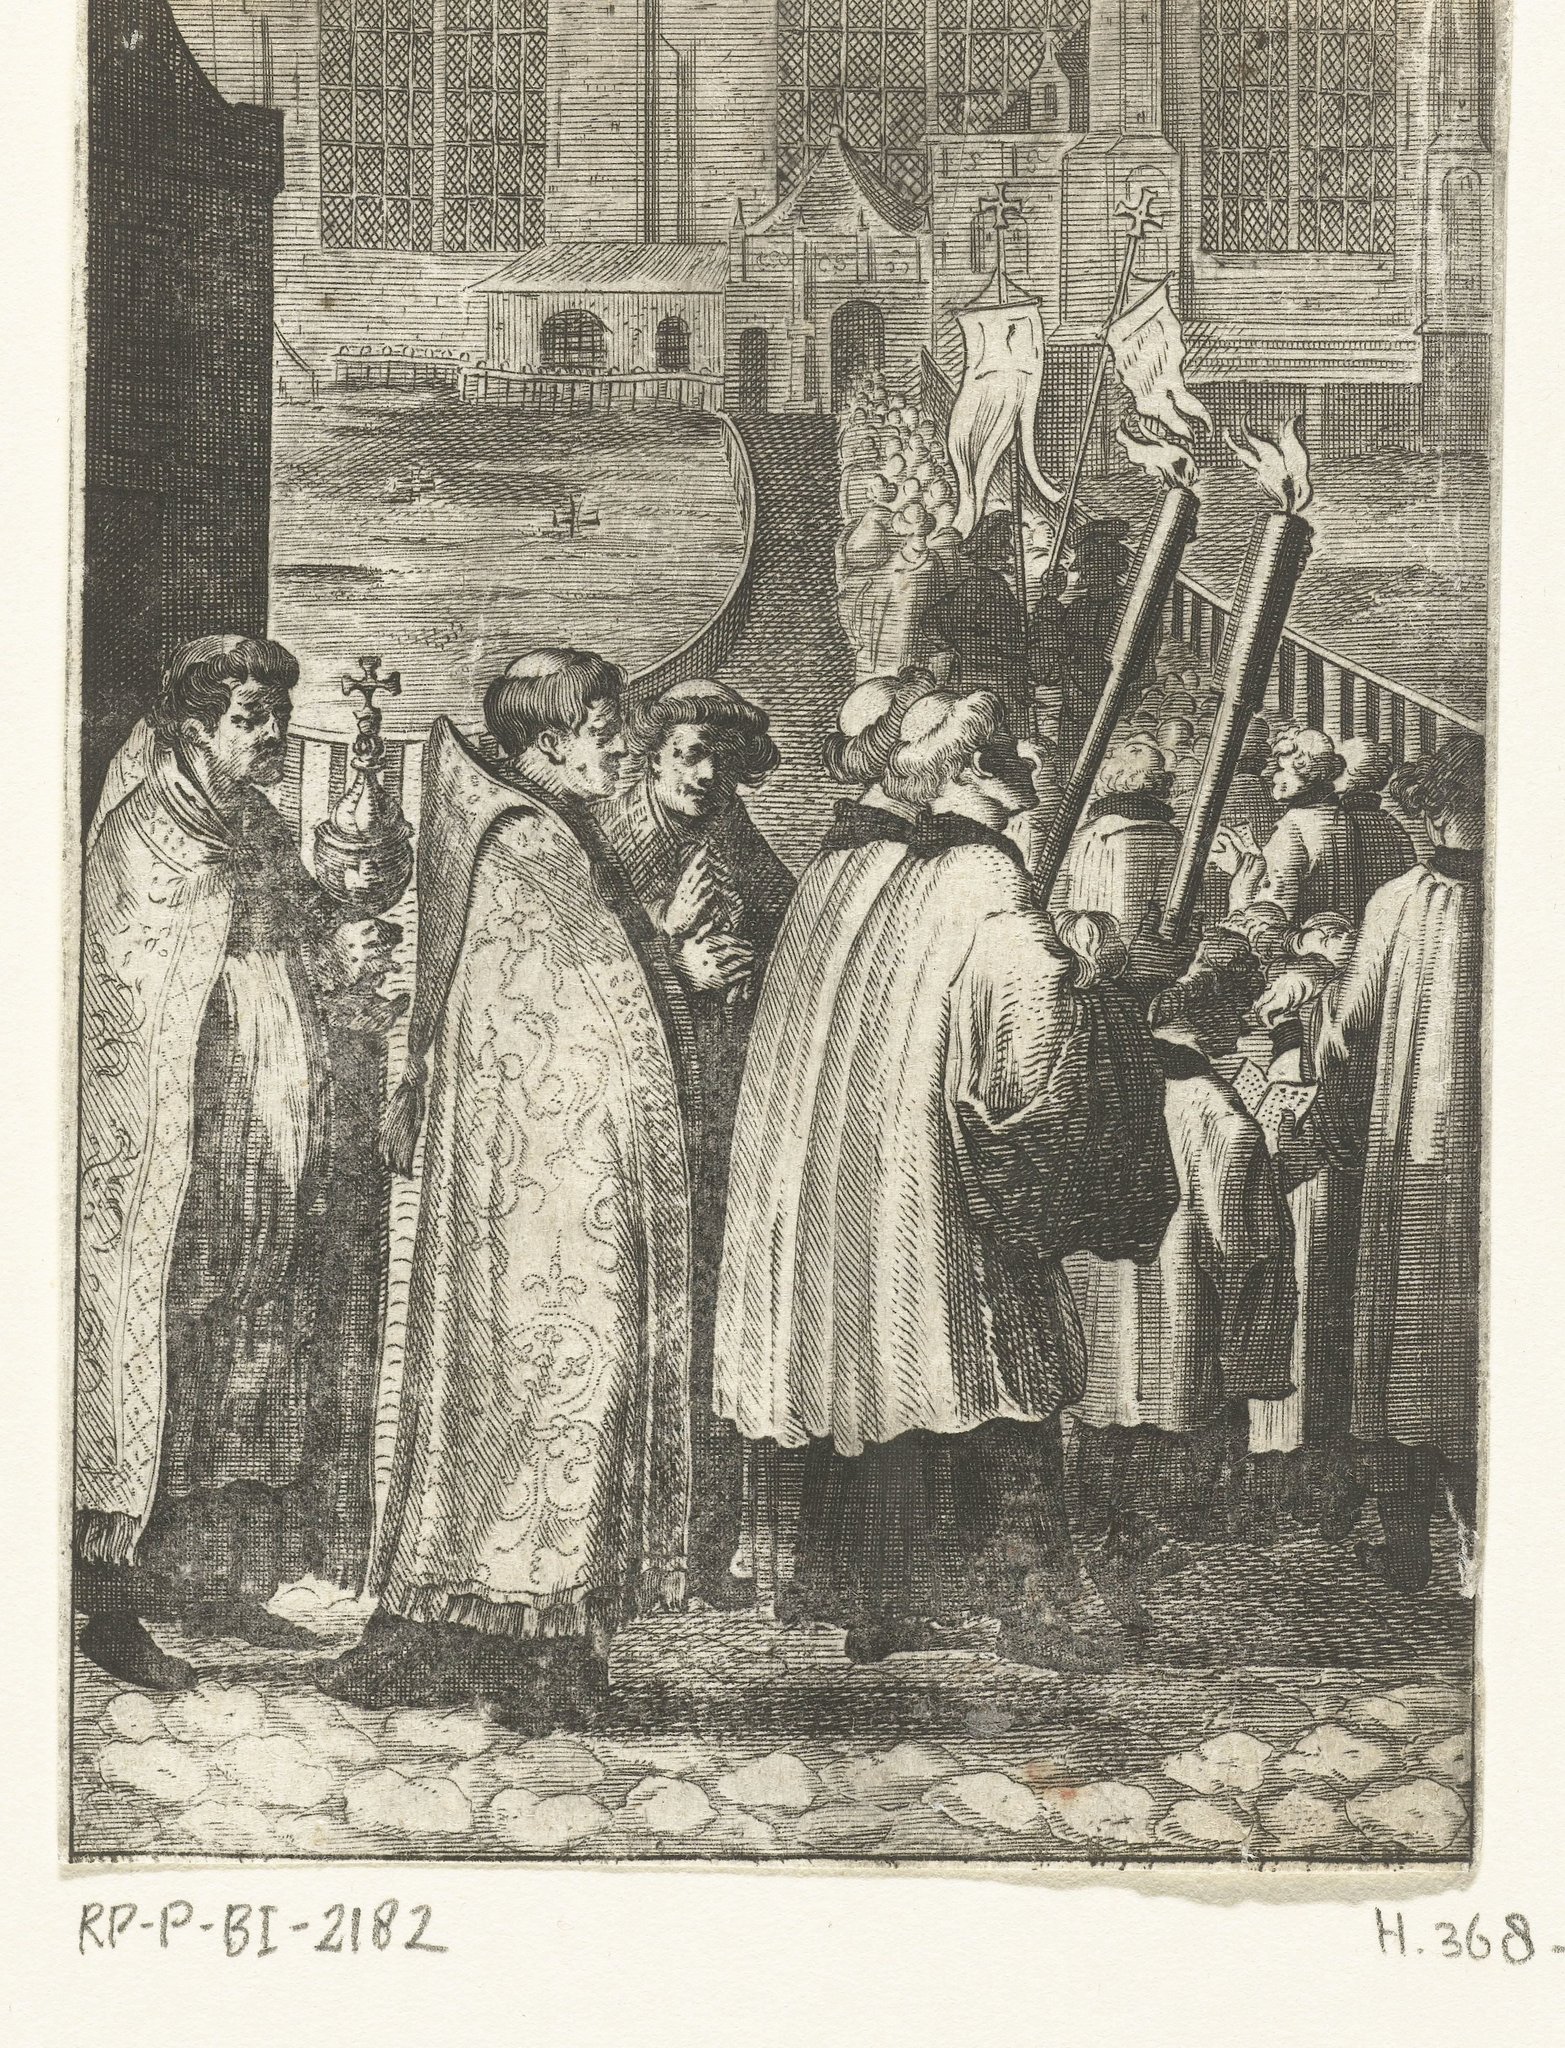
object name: print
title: Hostie wordt in processie naar de kerk gebracht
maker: Anonymous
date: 1639-1689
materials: paper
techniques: engraving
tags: legends and miracles associated with the eucharist (or the host), patient, sick person, procession ~ christian religion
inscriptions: collector's mark: Lugt 240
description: Kopie naar prent van Boëtius Adamsz. Bolswert. Hij op zijn beurt gebruikte een ontwerp van Jacob Cornelisz. van Oostsanen.